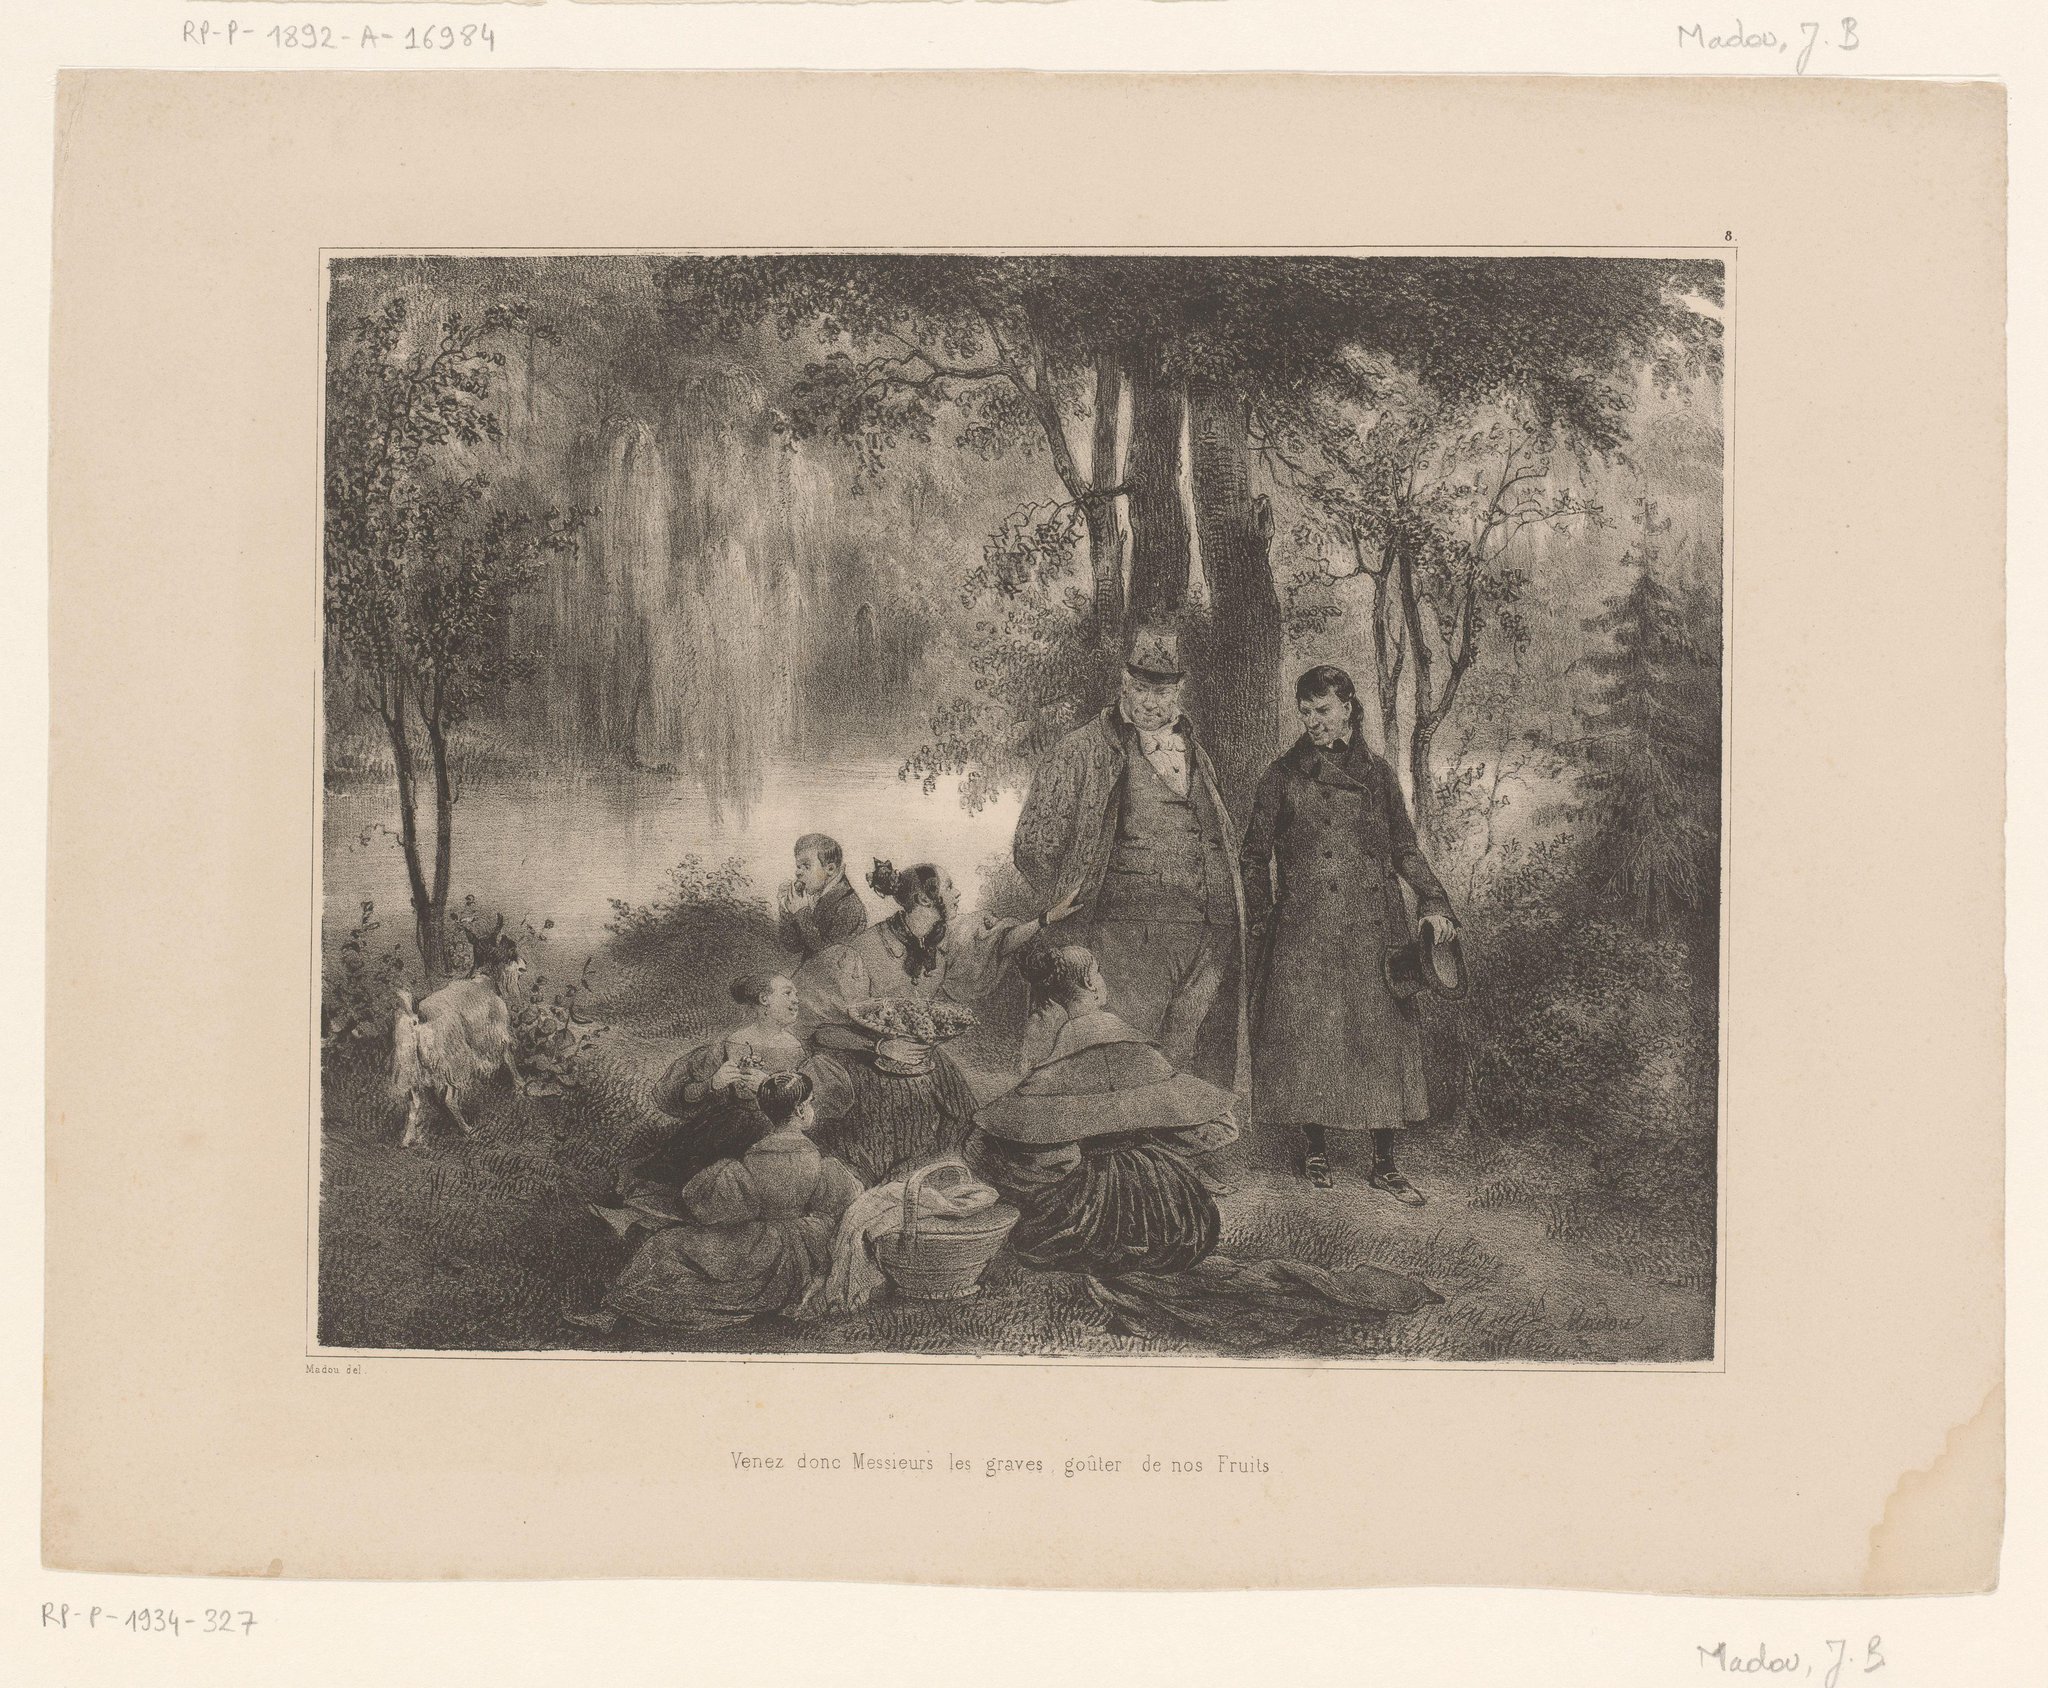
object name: print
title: Belgische familietaferelen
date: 1806-1877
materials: paper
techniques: lithograph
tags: picnic, alfresco, 'déjeuner sur l'herbe', landscapes with waters, waterscapes, seascapes (in the temperate zone) (+ landscape with figures, staffage), fruits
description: Prent maakt deel uit van een serie met Belgische familietaferelen. Over deze serie is verder niets bekend. Het betreft voornamelijk huiselijke taferelen.